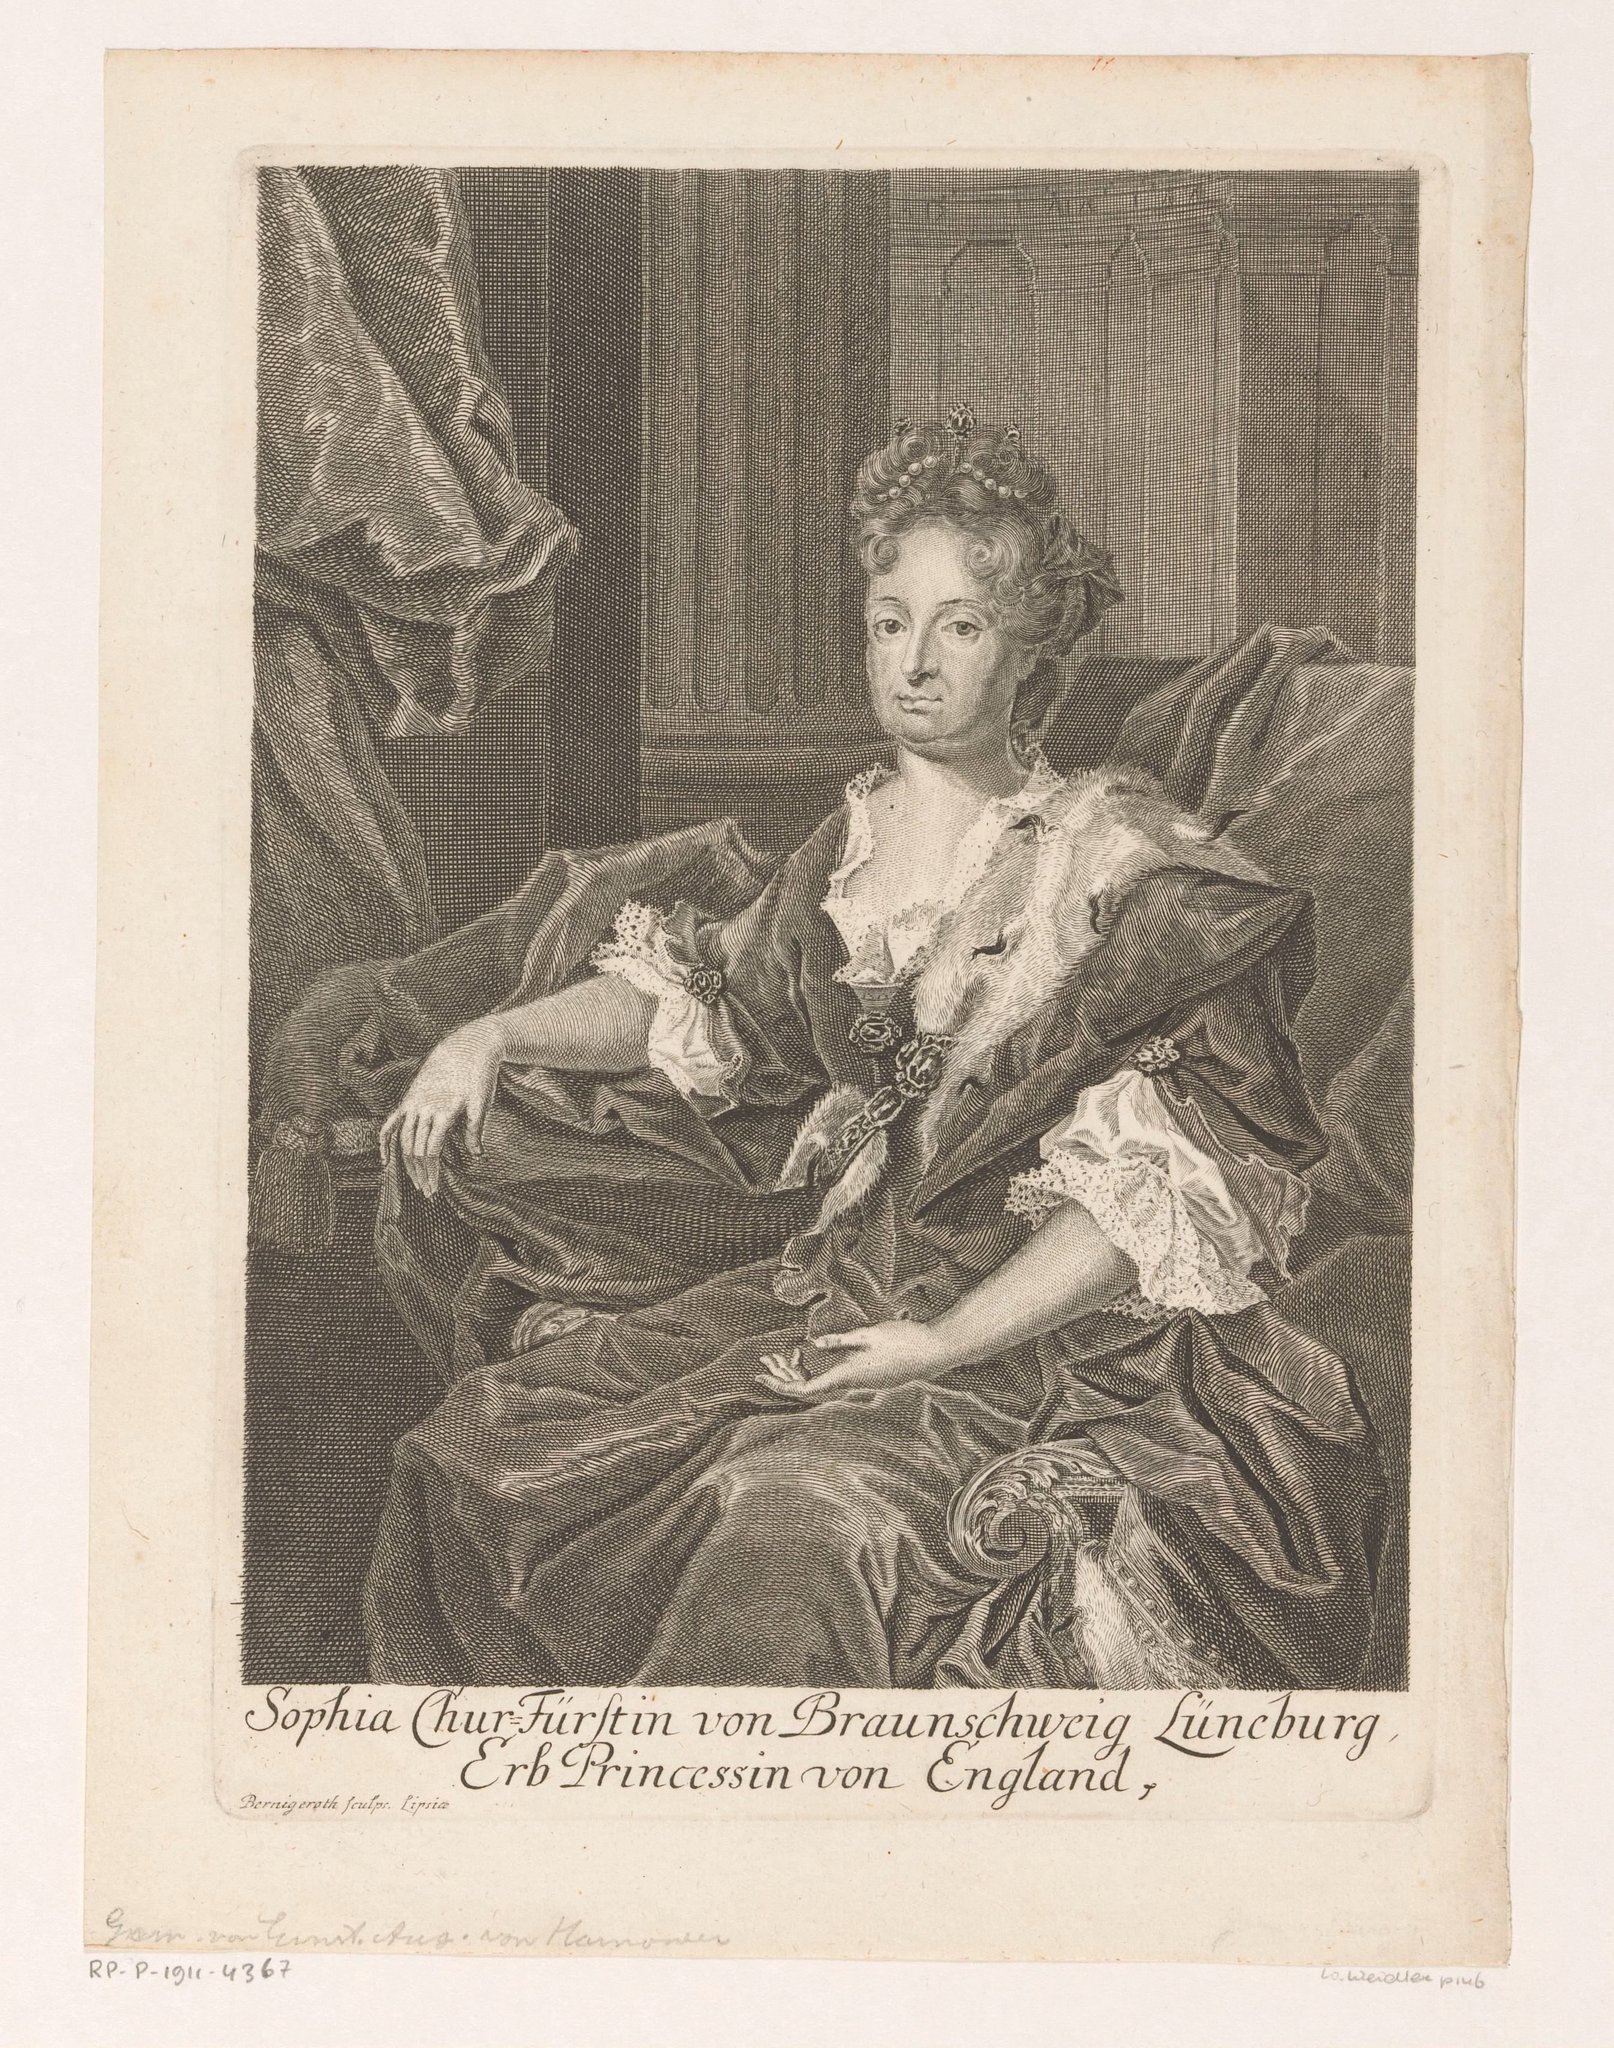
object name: print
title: Portret van Sophia van Hannover, hertogin van Brunswijk-Luneburg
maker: johann martin bernigeroth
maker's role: print maker, publisher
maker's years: 1713-1767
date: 1701-1714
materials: paper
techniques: engraving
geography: leipzig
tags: the hague, historical persons - bb - woman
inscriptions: collector's mark: Lugt 2228